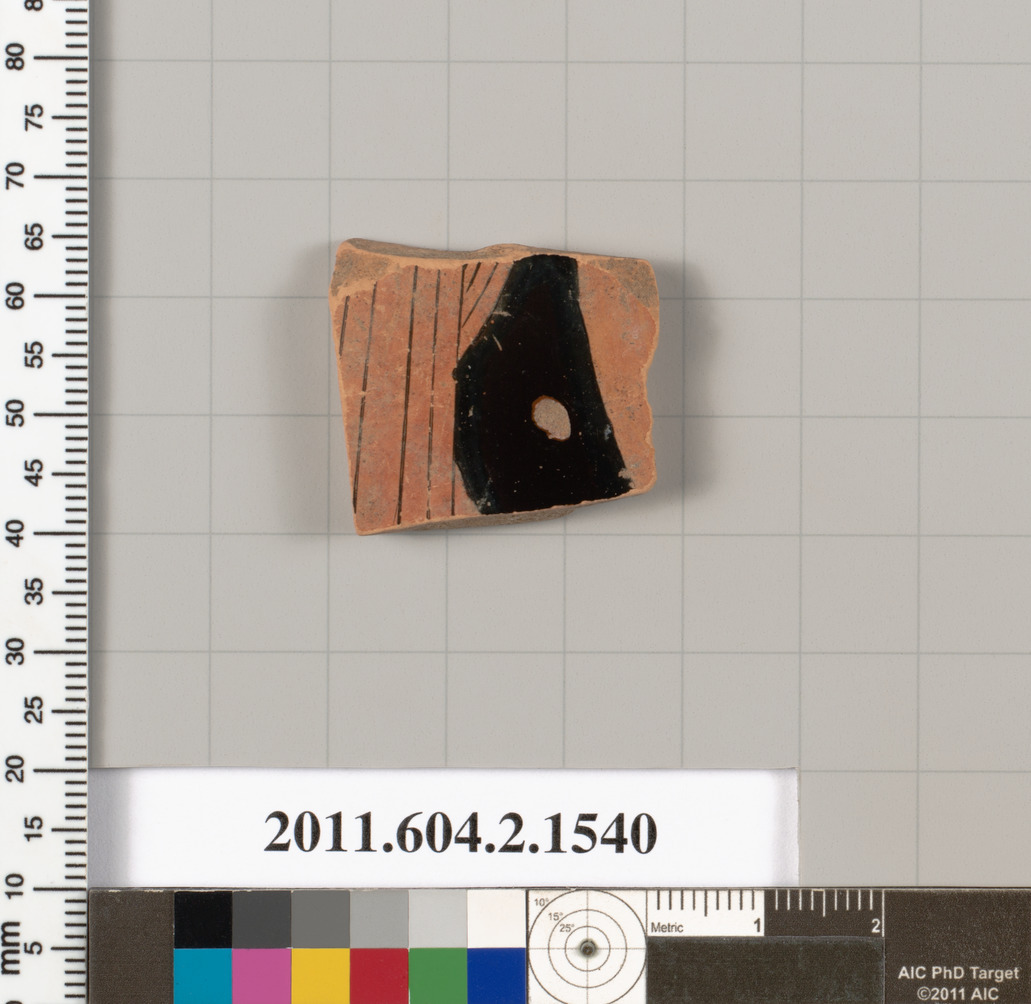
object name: skyphos fragment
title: Terracotta fragment of a skyphos (deep drinking cup)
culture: greek, attic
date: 467-435 BCE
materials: terracotta